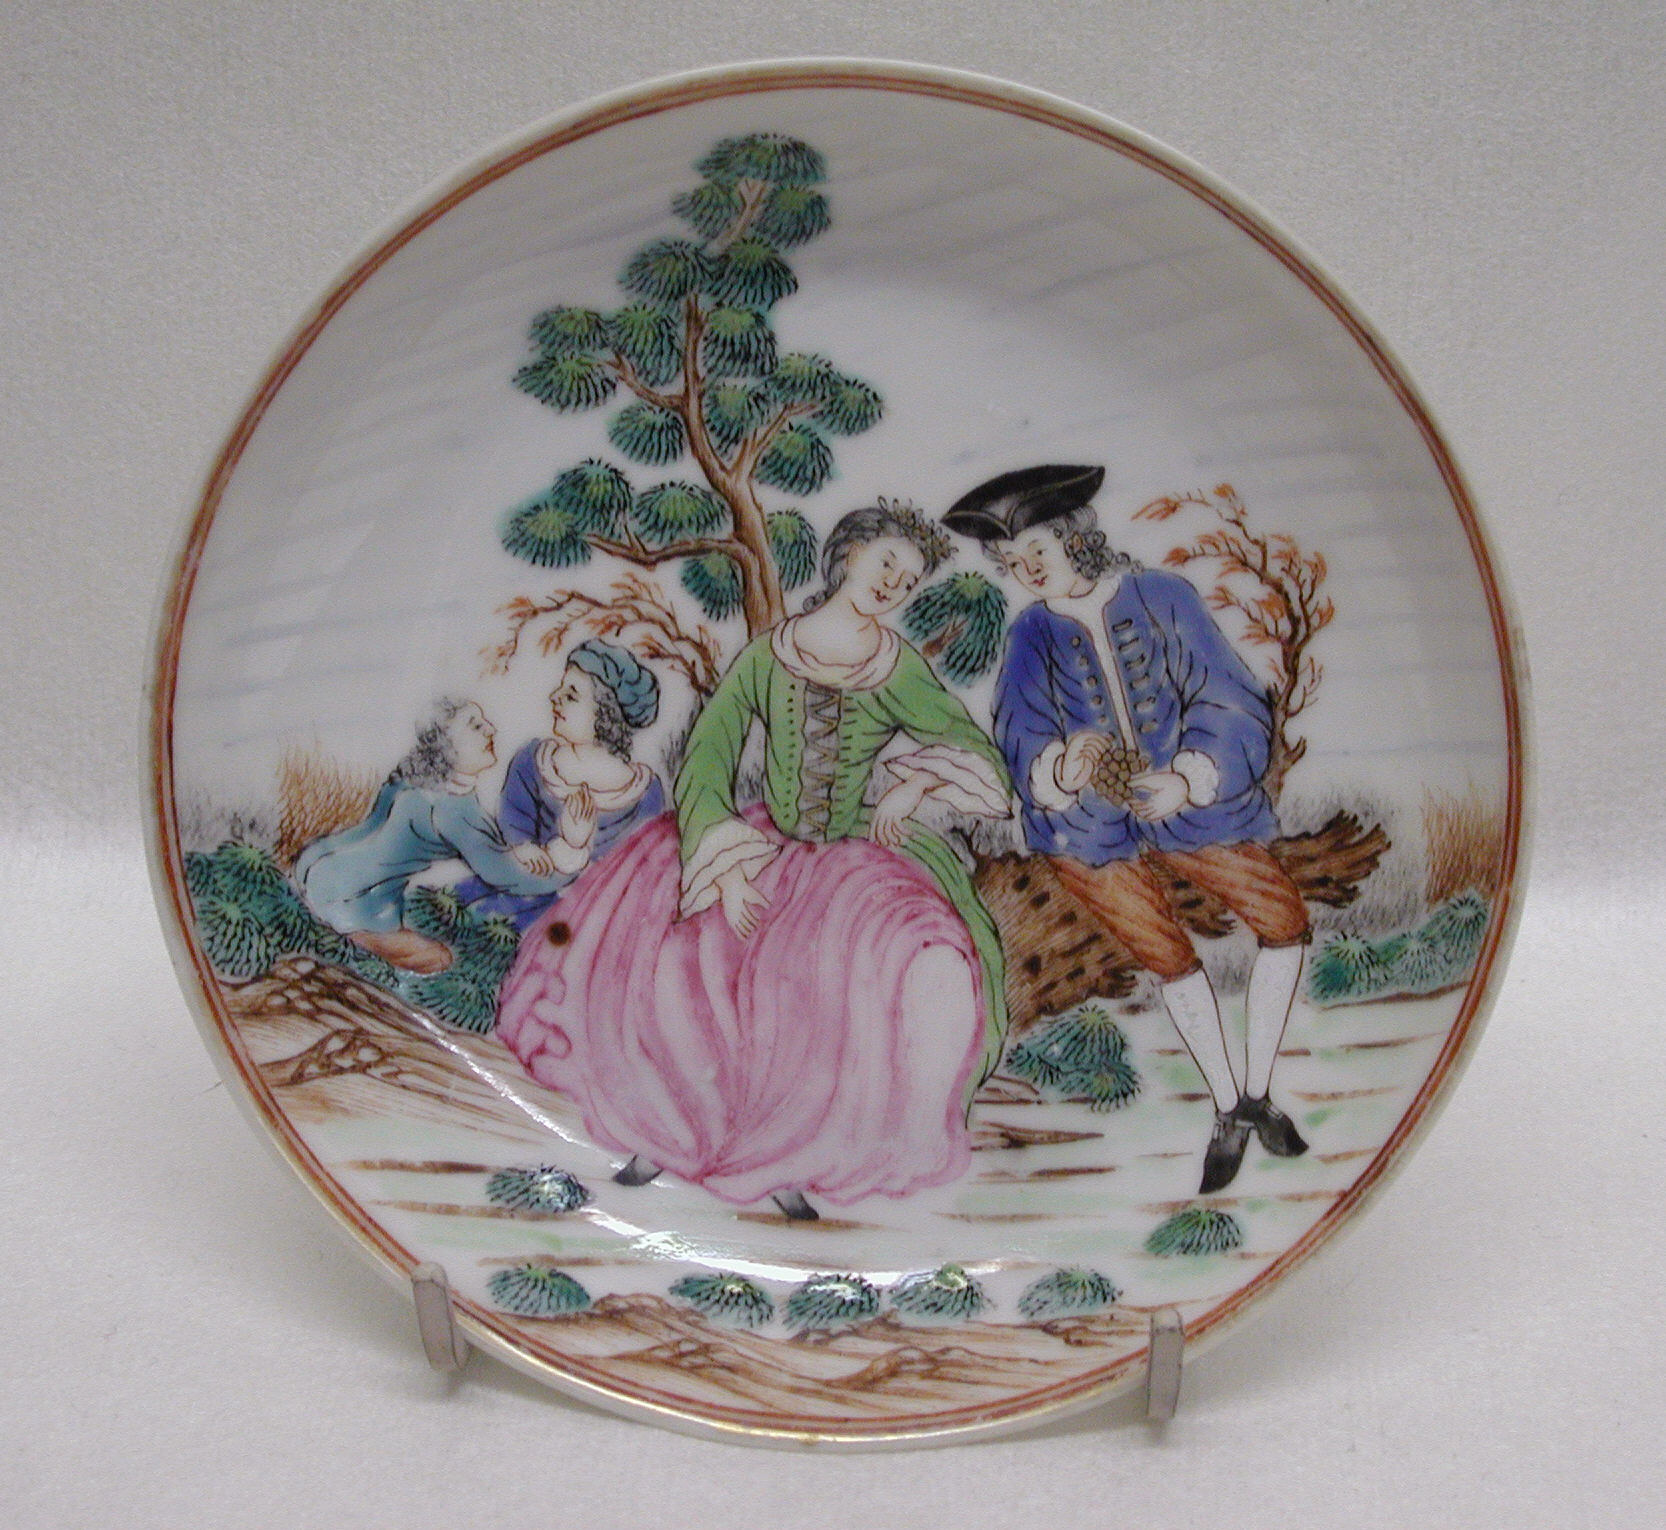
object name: teabowl and saucer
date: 1765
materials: hard paste porcelain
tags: men,women,trees